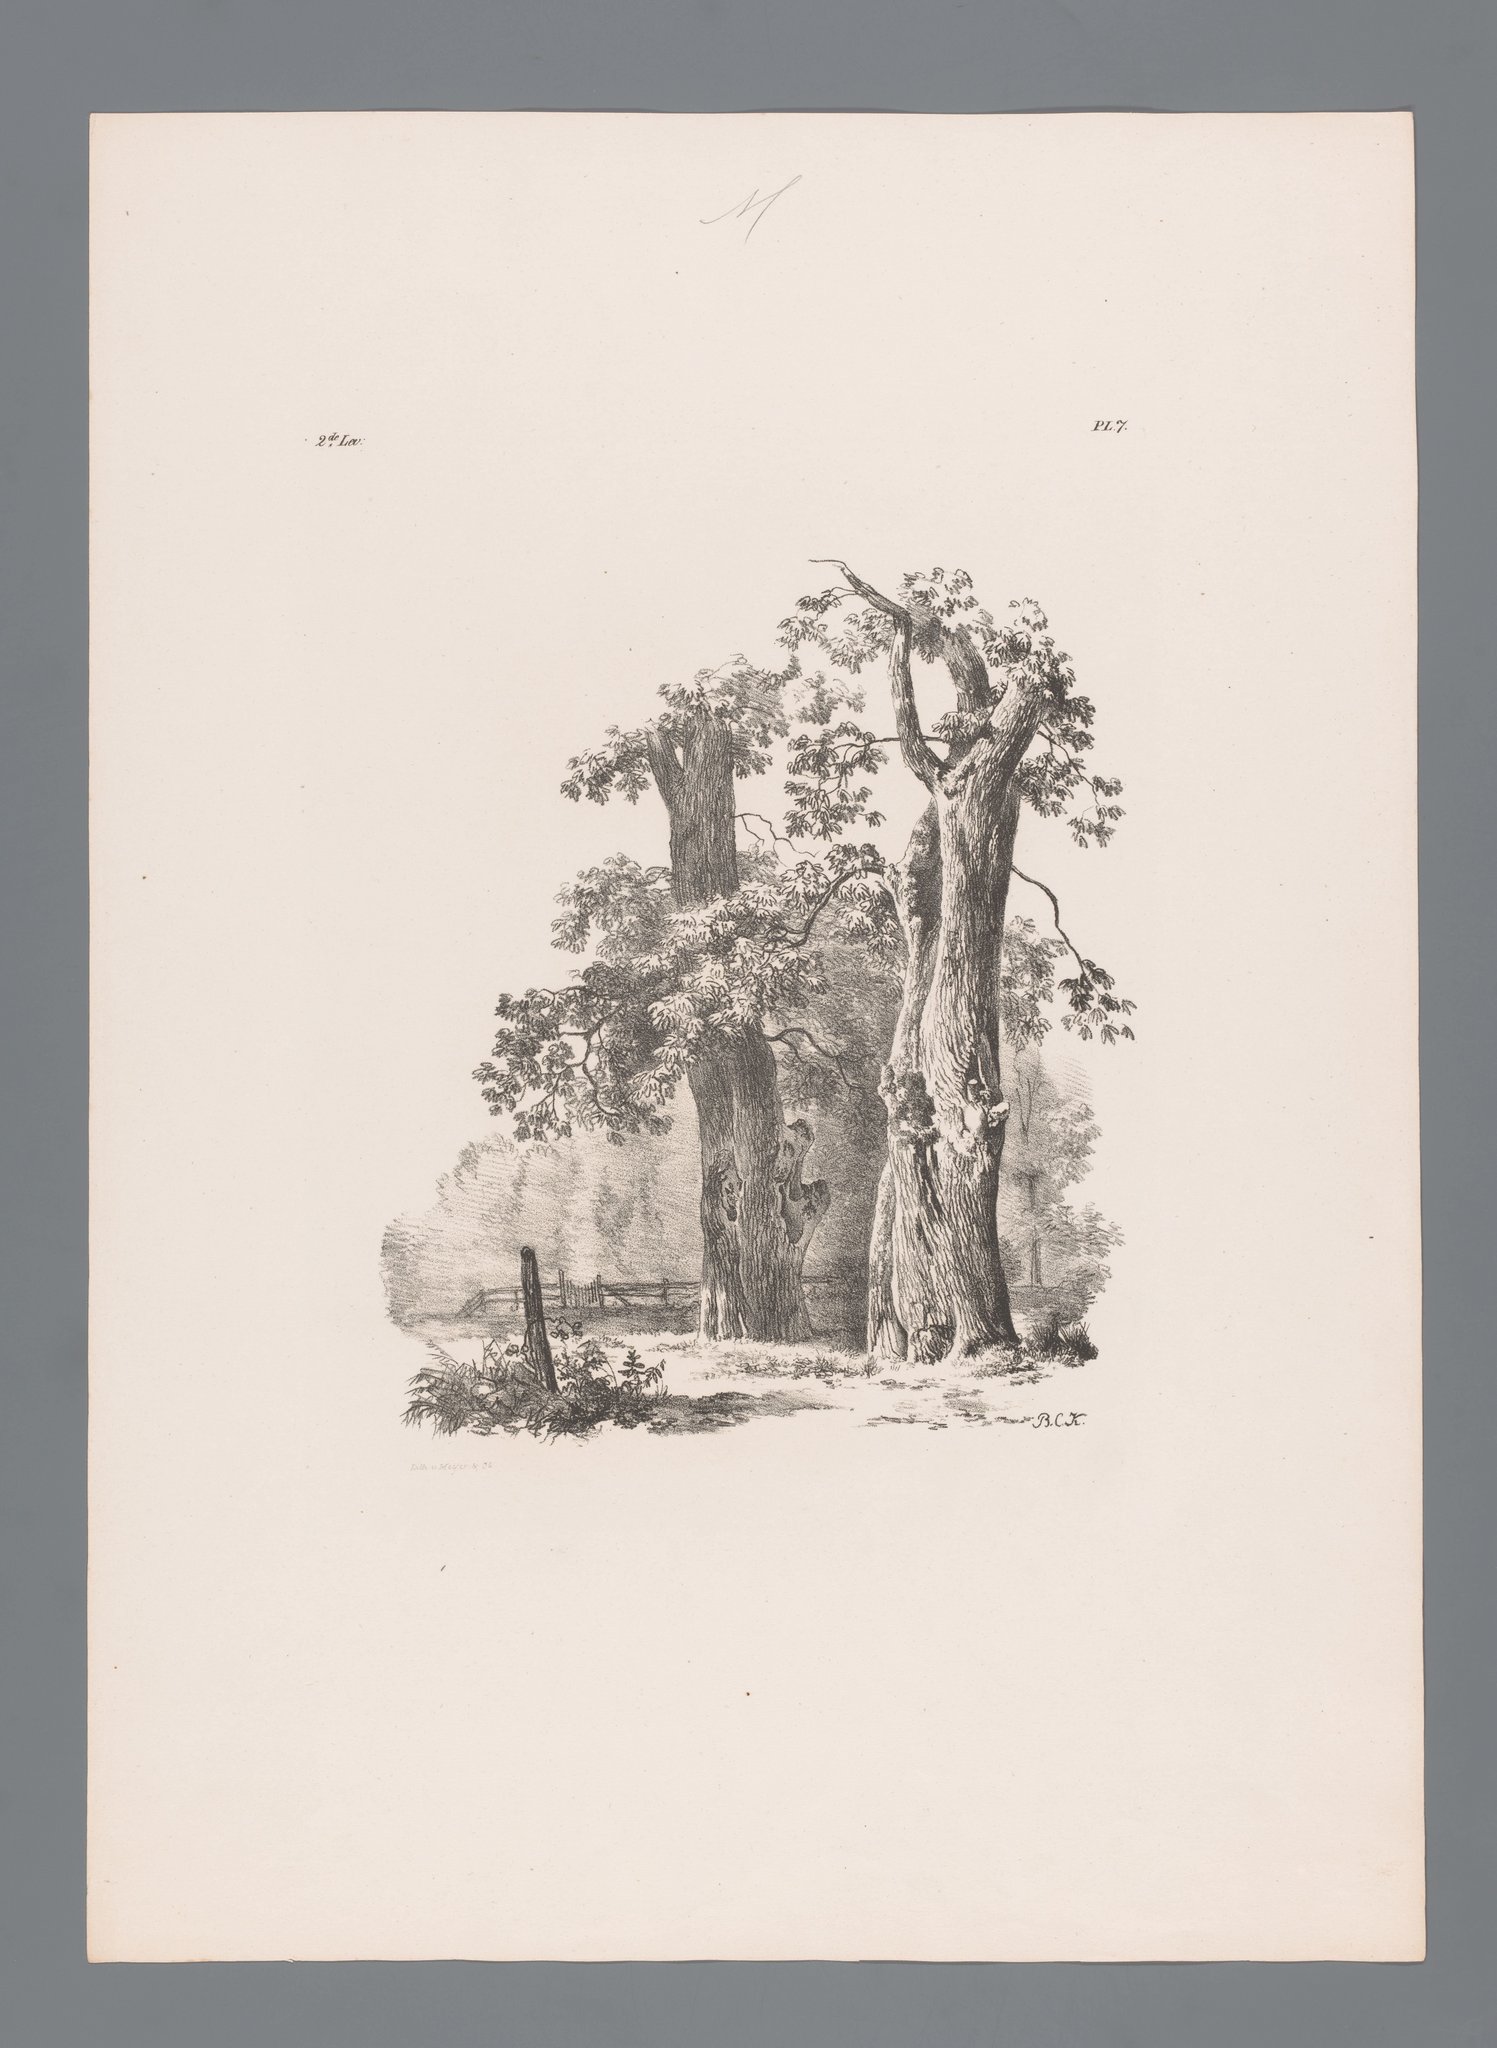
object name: print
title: Landschap studiën tweede levering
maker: barend cornelis koekkoek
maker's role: draughtsman, painter, print maker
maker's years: 1803-1862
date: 1844-1845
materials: paper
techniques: lithograph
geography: amsterdam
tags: gate, entrance, groups of trees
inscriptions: collector's mark: Lugt 2228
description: In 1829 en 1830 gaf Koekkoek, samen met Daiwaille, zes cahiers uit met ieder zes prenten getiteld Landschapstudiën. Deze werden gebruikt in het tekenonderwijs. Vijftien jaar later werd deze reeks, in een andere samenstelling nogmaals uitgegeven door Meyer en Comp in Amsterdam. Zie: De Bruyn Kops, 1963.